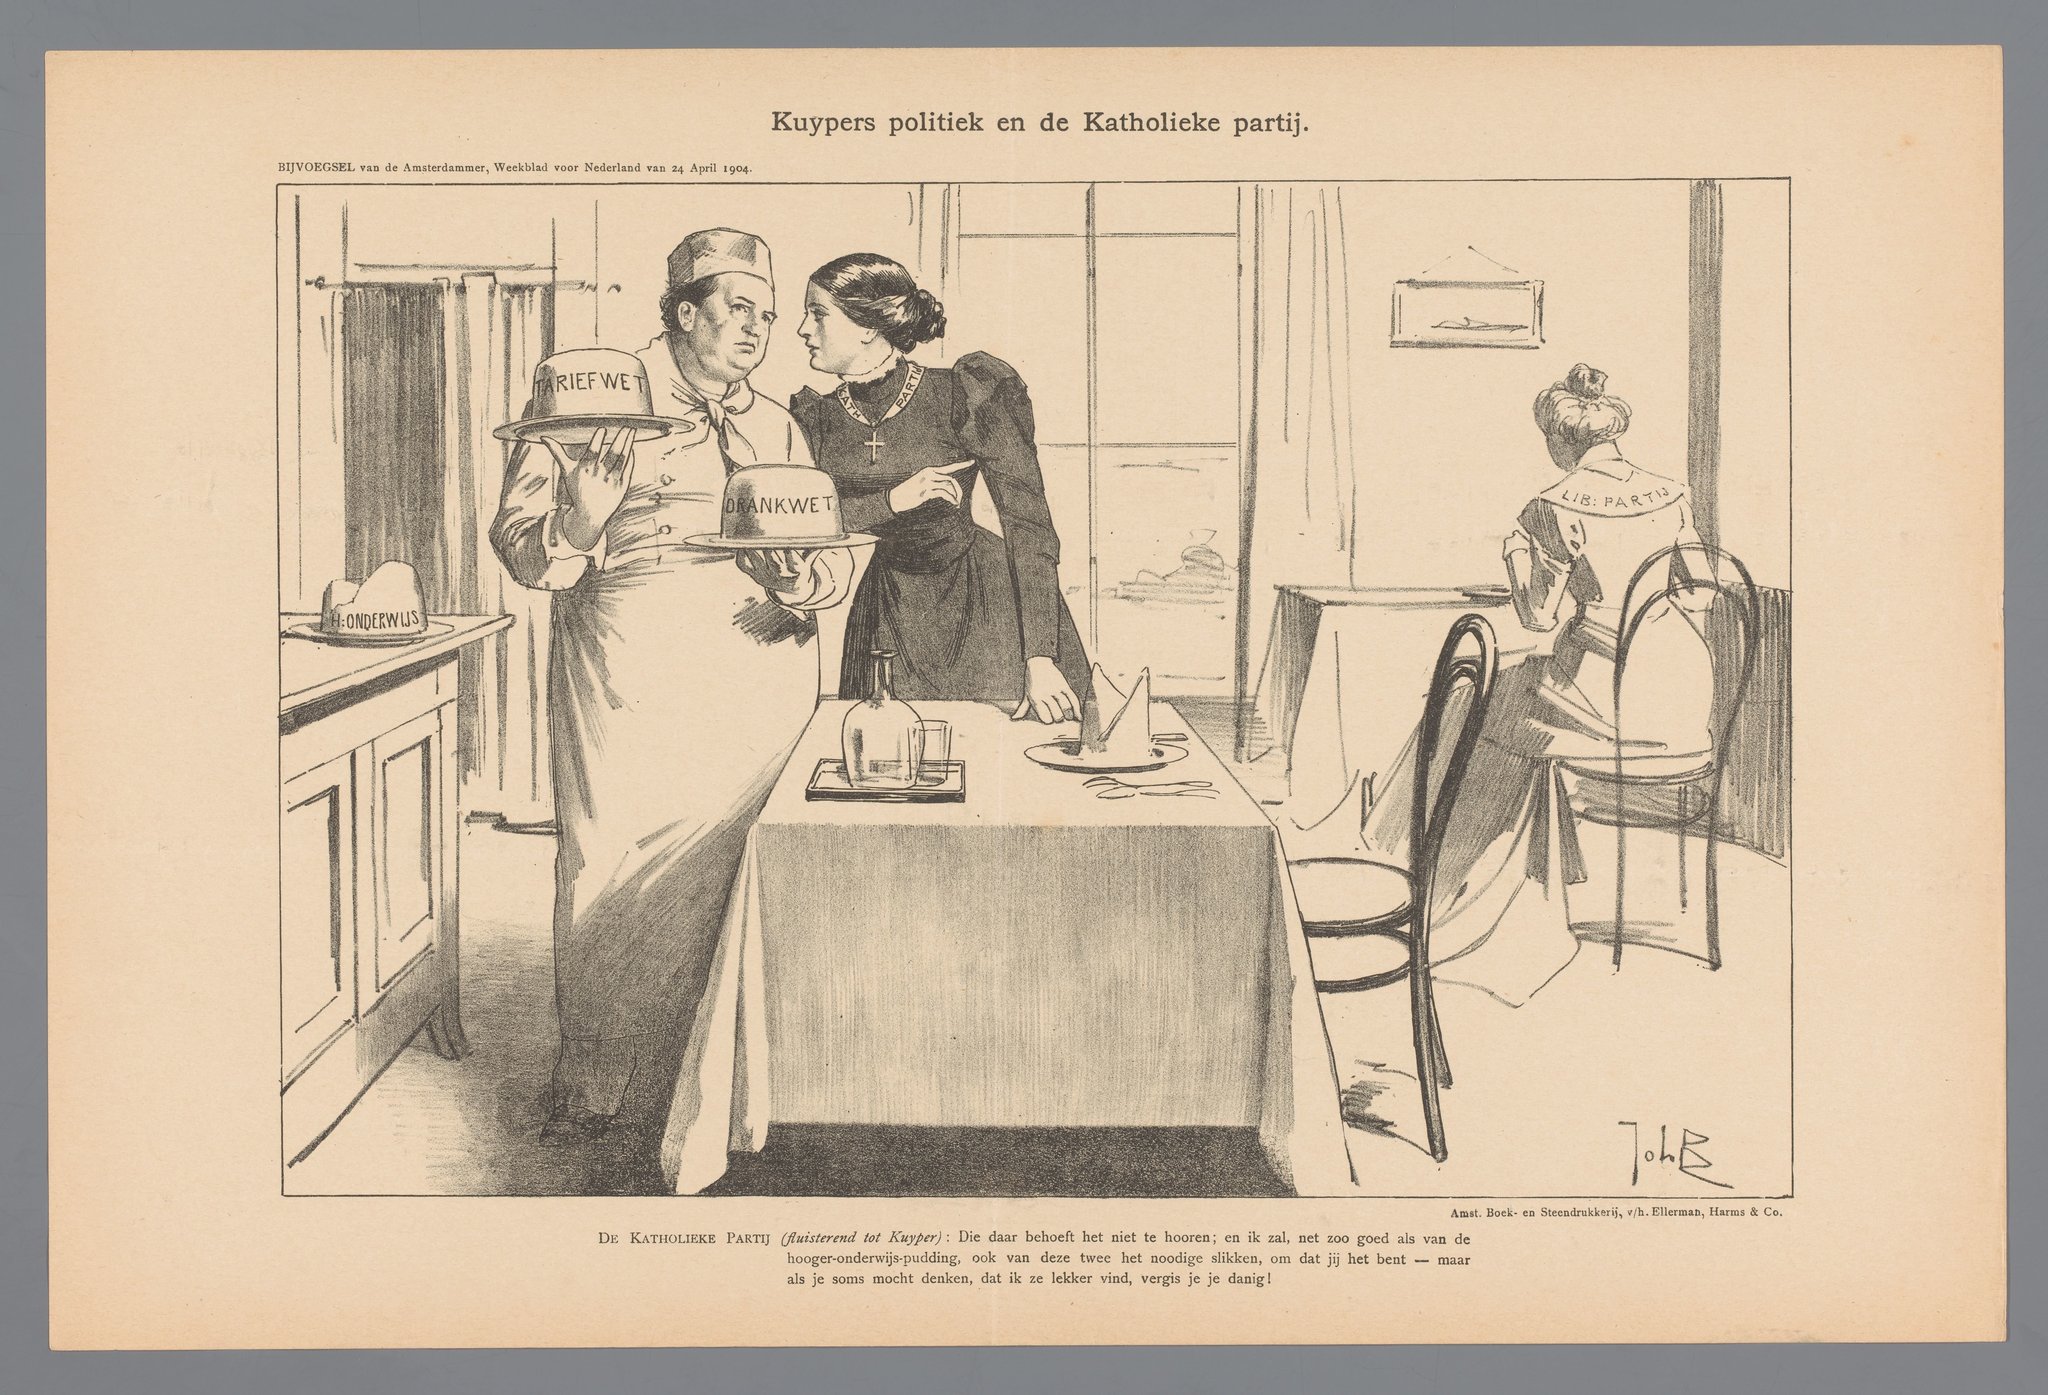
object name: cartoon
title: Kuypers politiek en de Katholieke partij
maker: johan braakensiek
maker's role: draughtsman, print maker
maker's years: 1858-1940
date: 1904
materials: paper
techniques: lithograph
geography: amsterdam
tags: the hague, abraham kuyper, historical persons, political caricatures and satires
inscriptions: date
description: Prent uit het bijvoegsel van: De Amsterdammer. Weekblad voor Nederland, 24 april 1904.